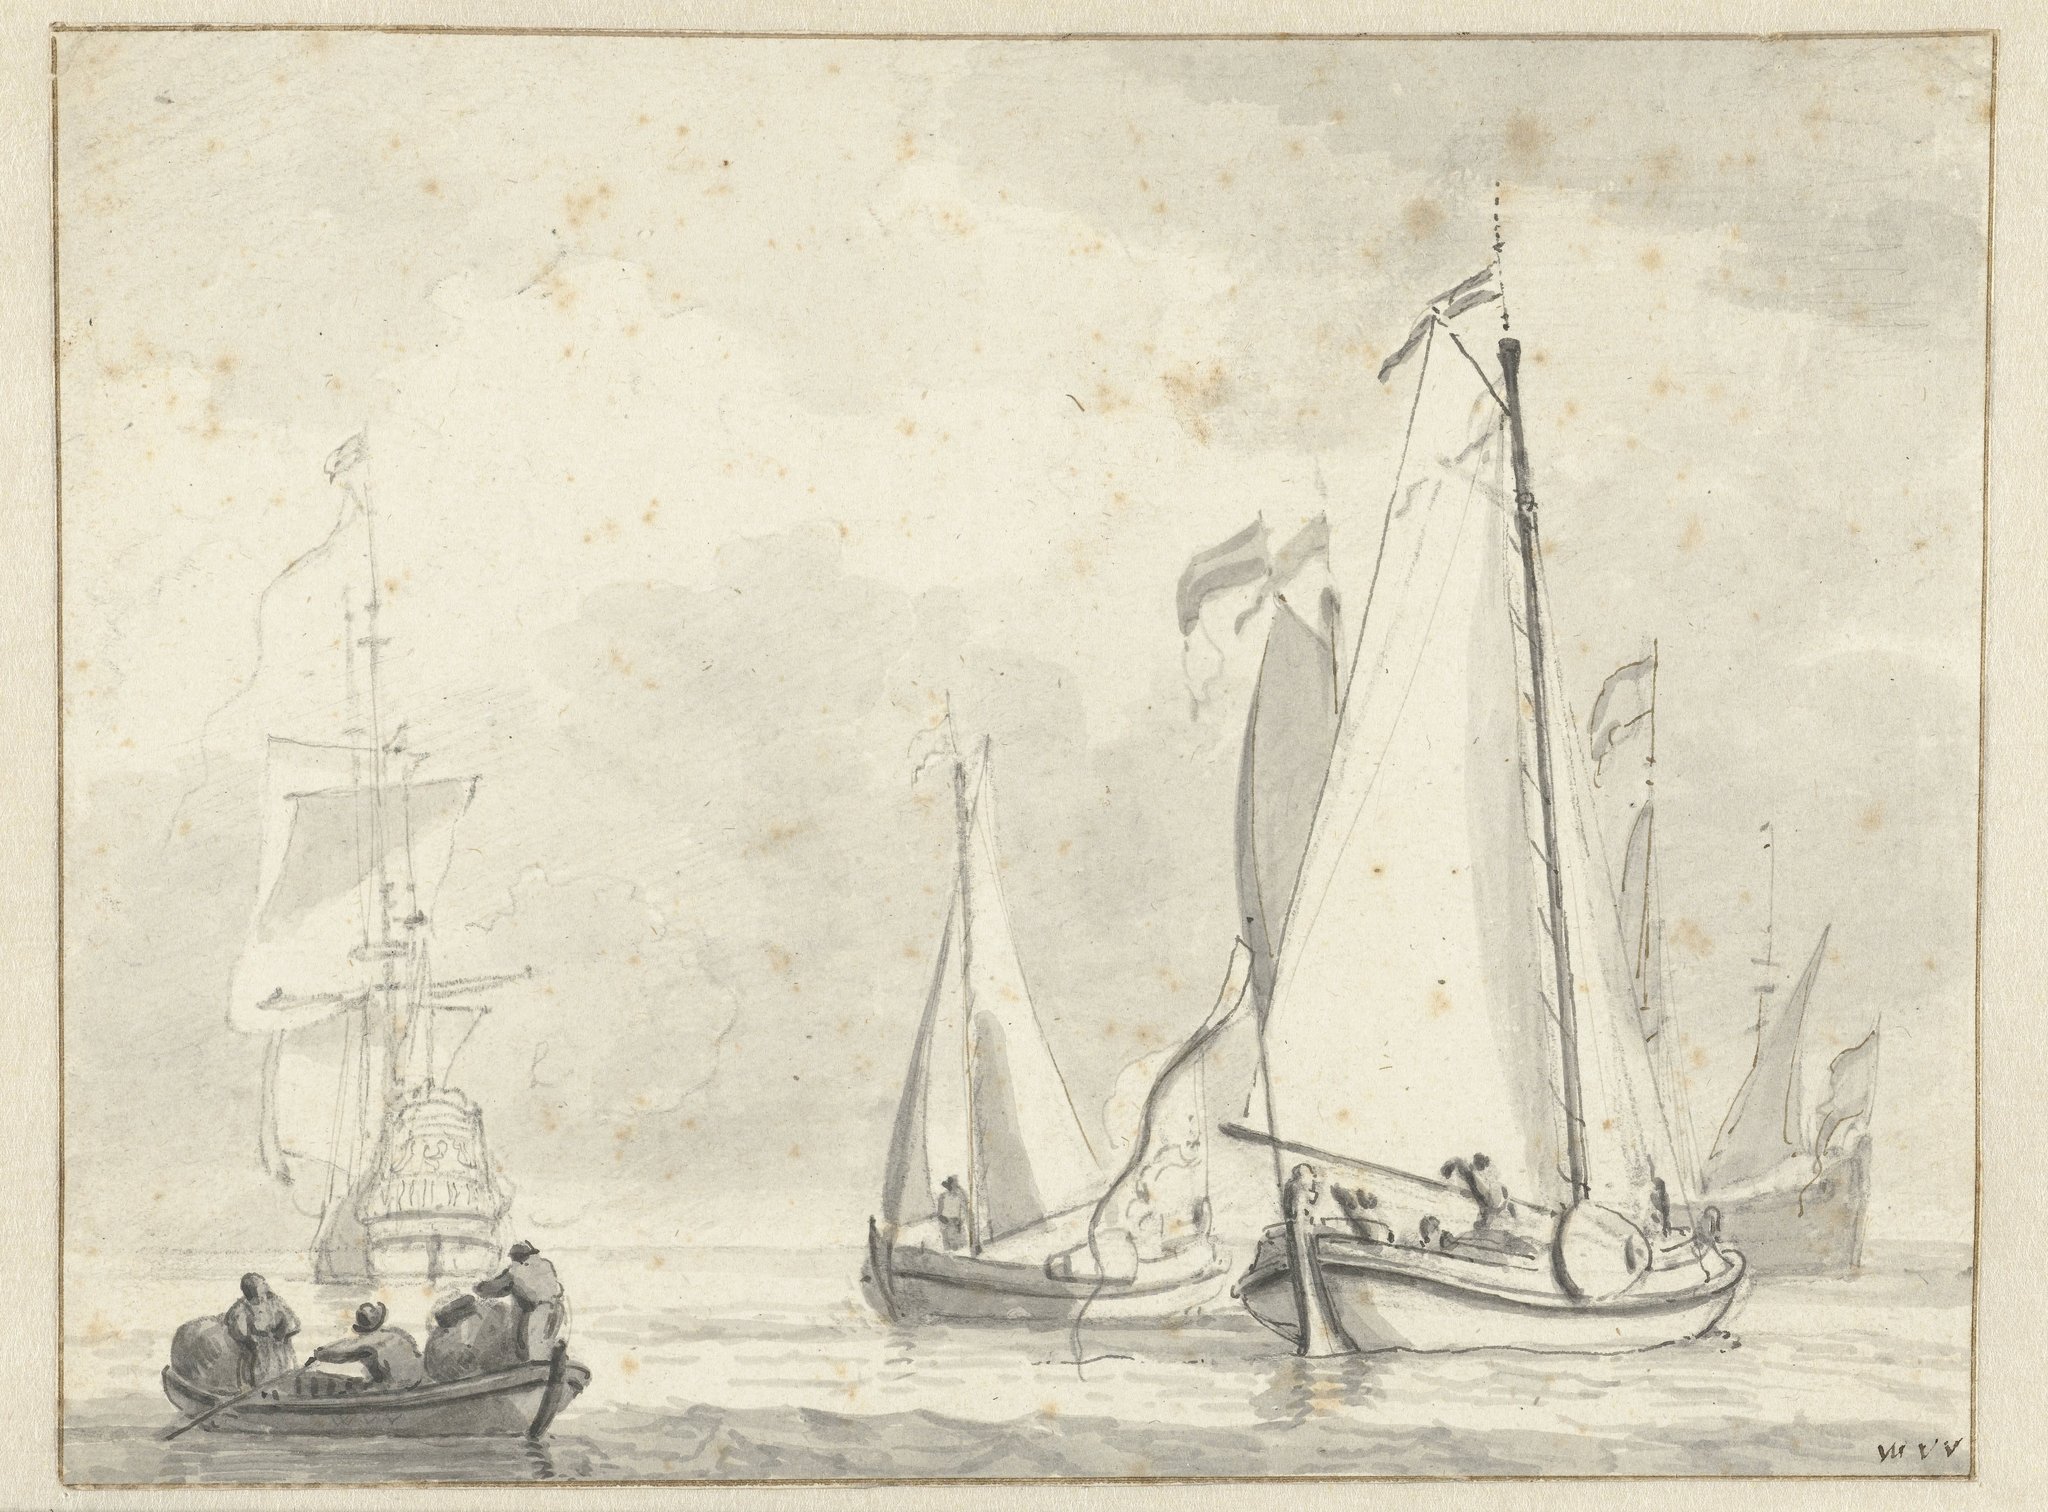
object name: drawing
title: Zeegezicht met enkele schepen op de rede liggend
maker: willem van de velde (ii)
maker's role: draughtsman, painter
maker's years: 1633-1707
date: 1643-1707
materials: ink, paper, pencil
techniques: brush, pen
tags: sailing-ship, sailing-boat, rowing-boat, canoe, etc., sea (seascape), ship in the roads, roadstead